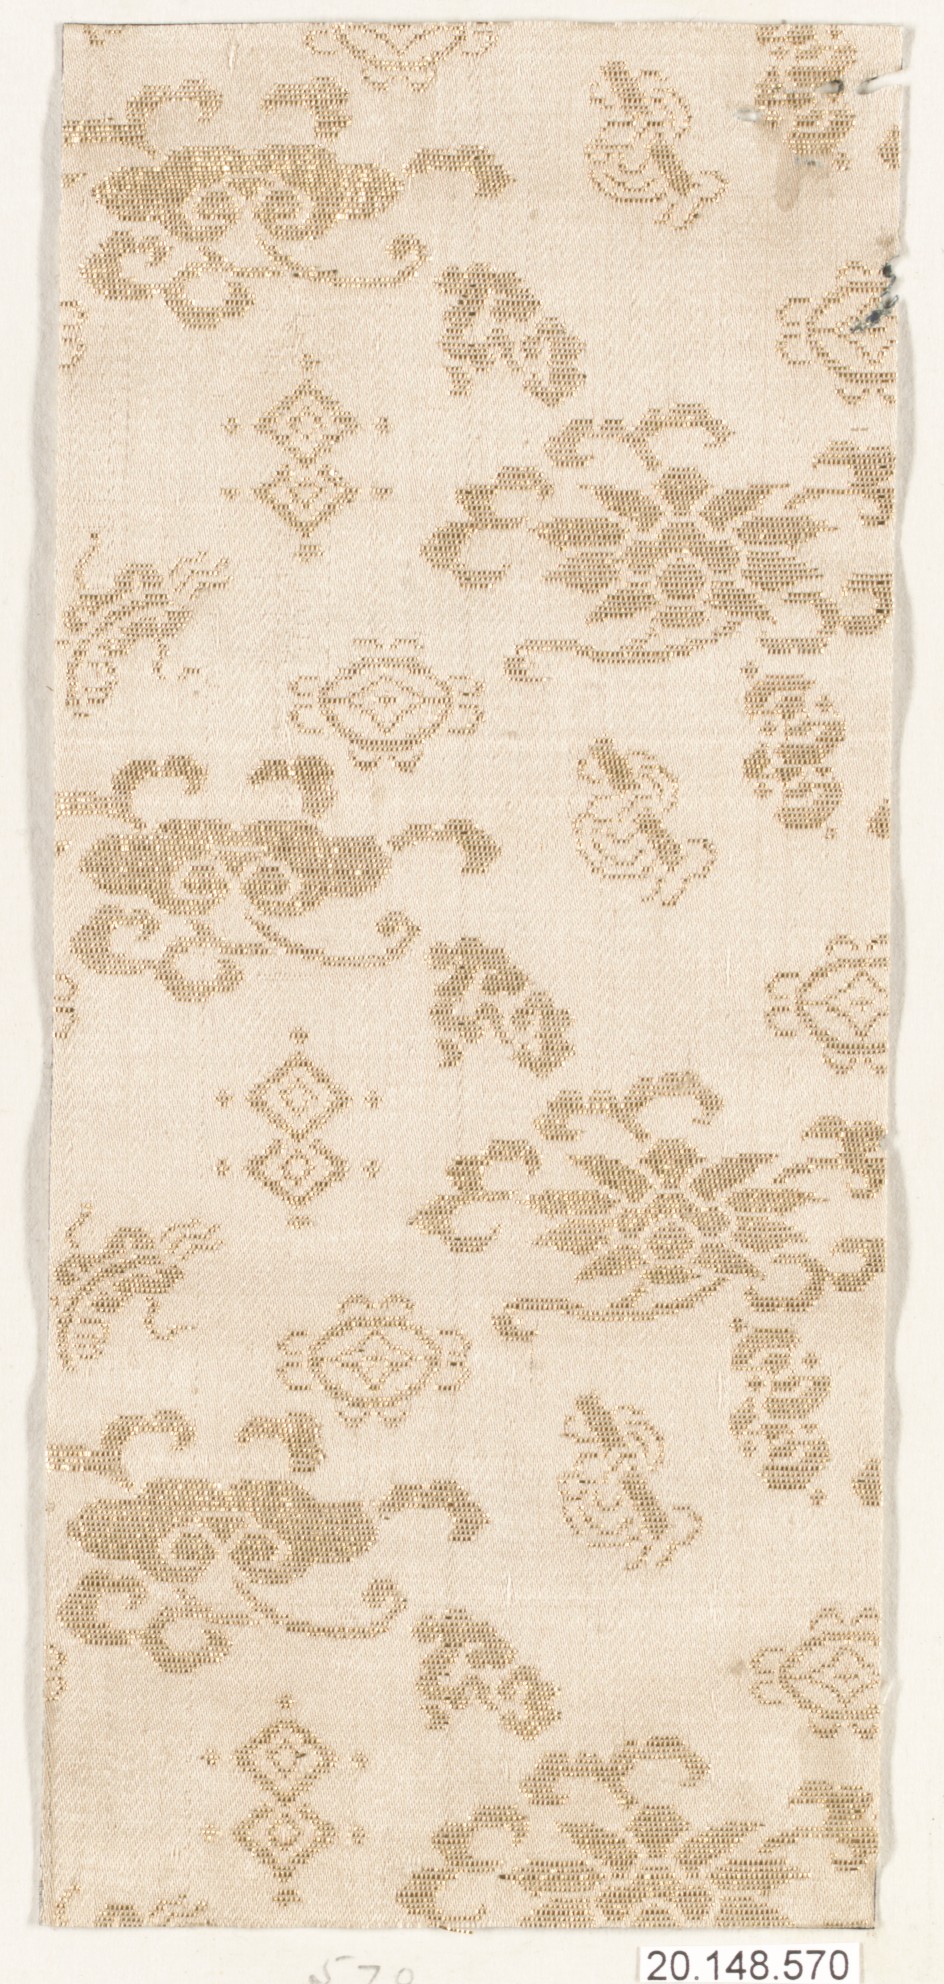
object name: piece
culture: japanese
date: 1701-1800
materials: silk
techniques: compound weave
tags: flowers